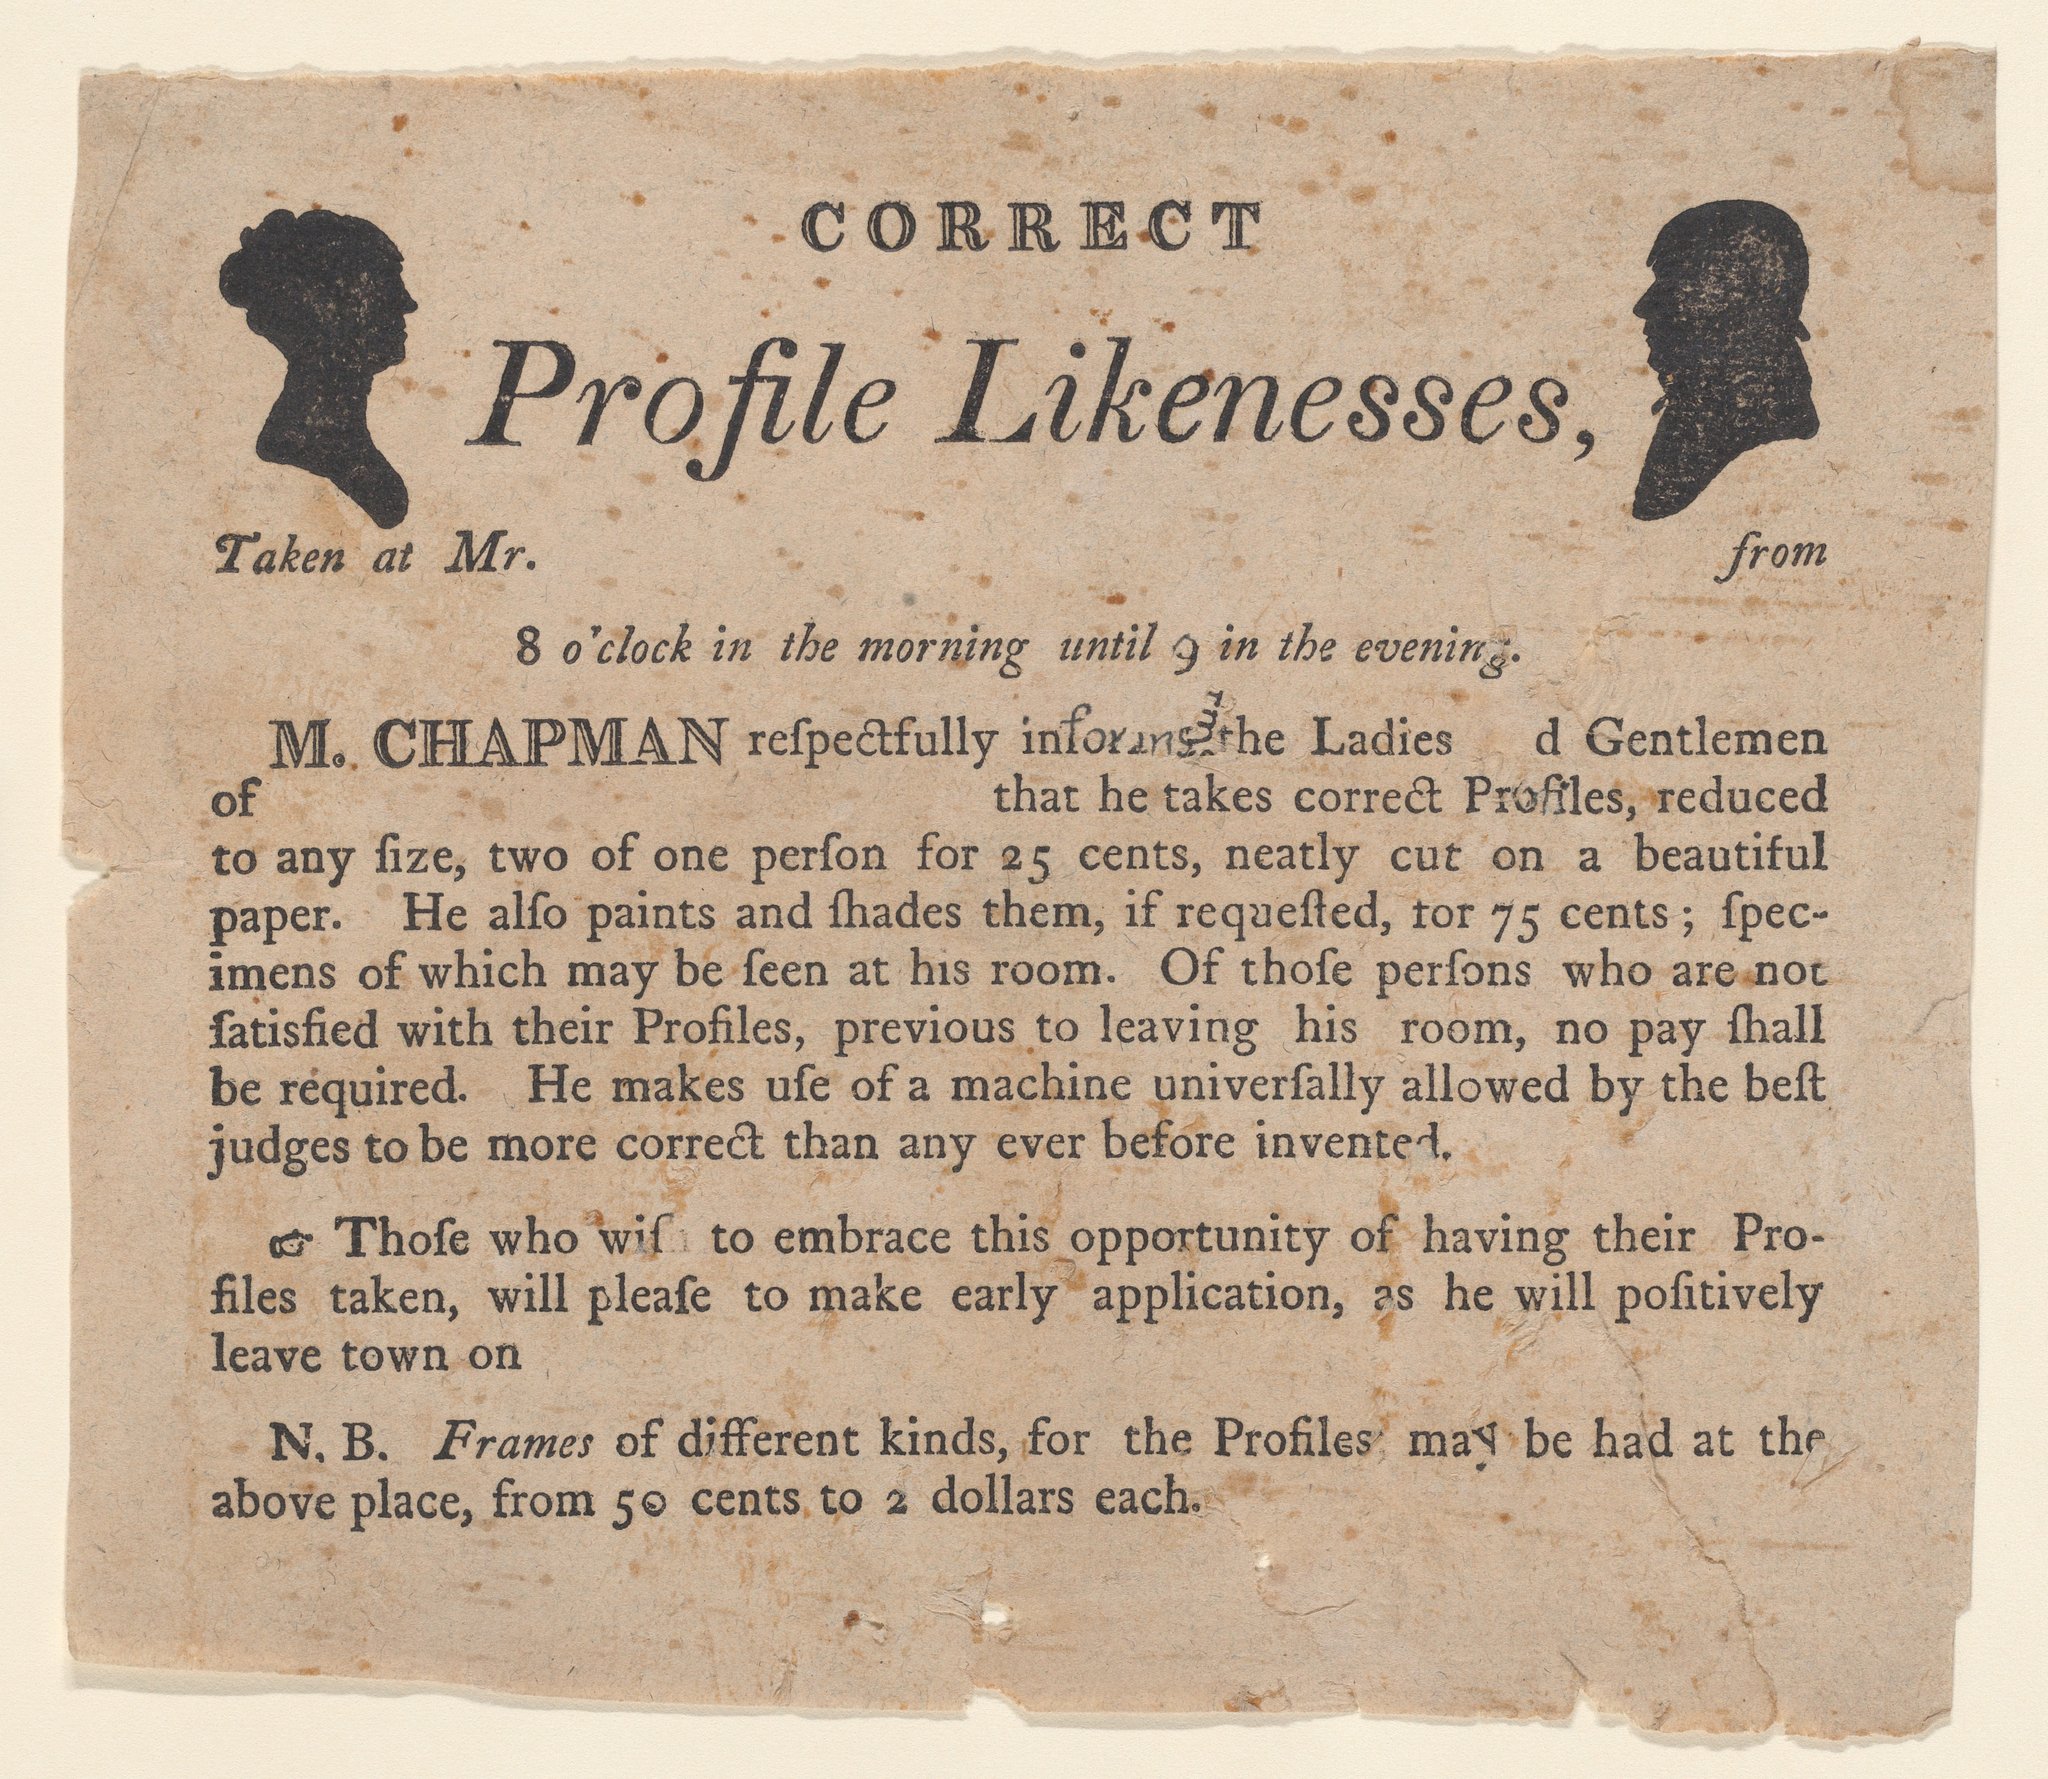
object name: print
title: Advertisement for profile likenesses by Moses Chapman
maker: Anonymous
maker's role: artist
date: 1803-1821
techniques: letterpress